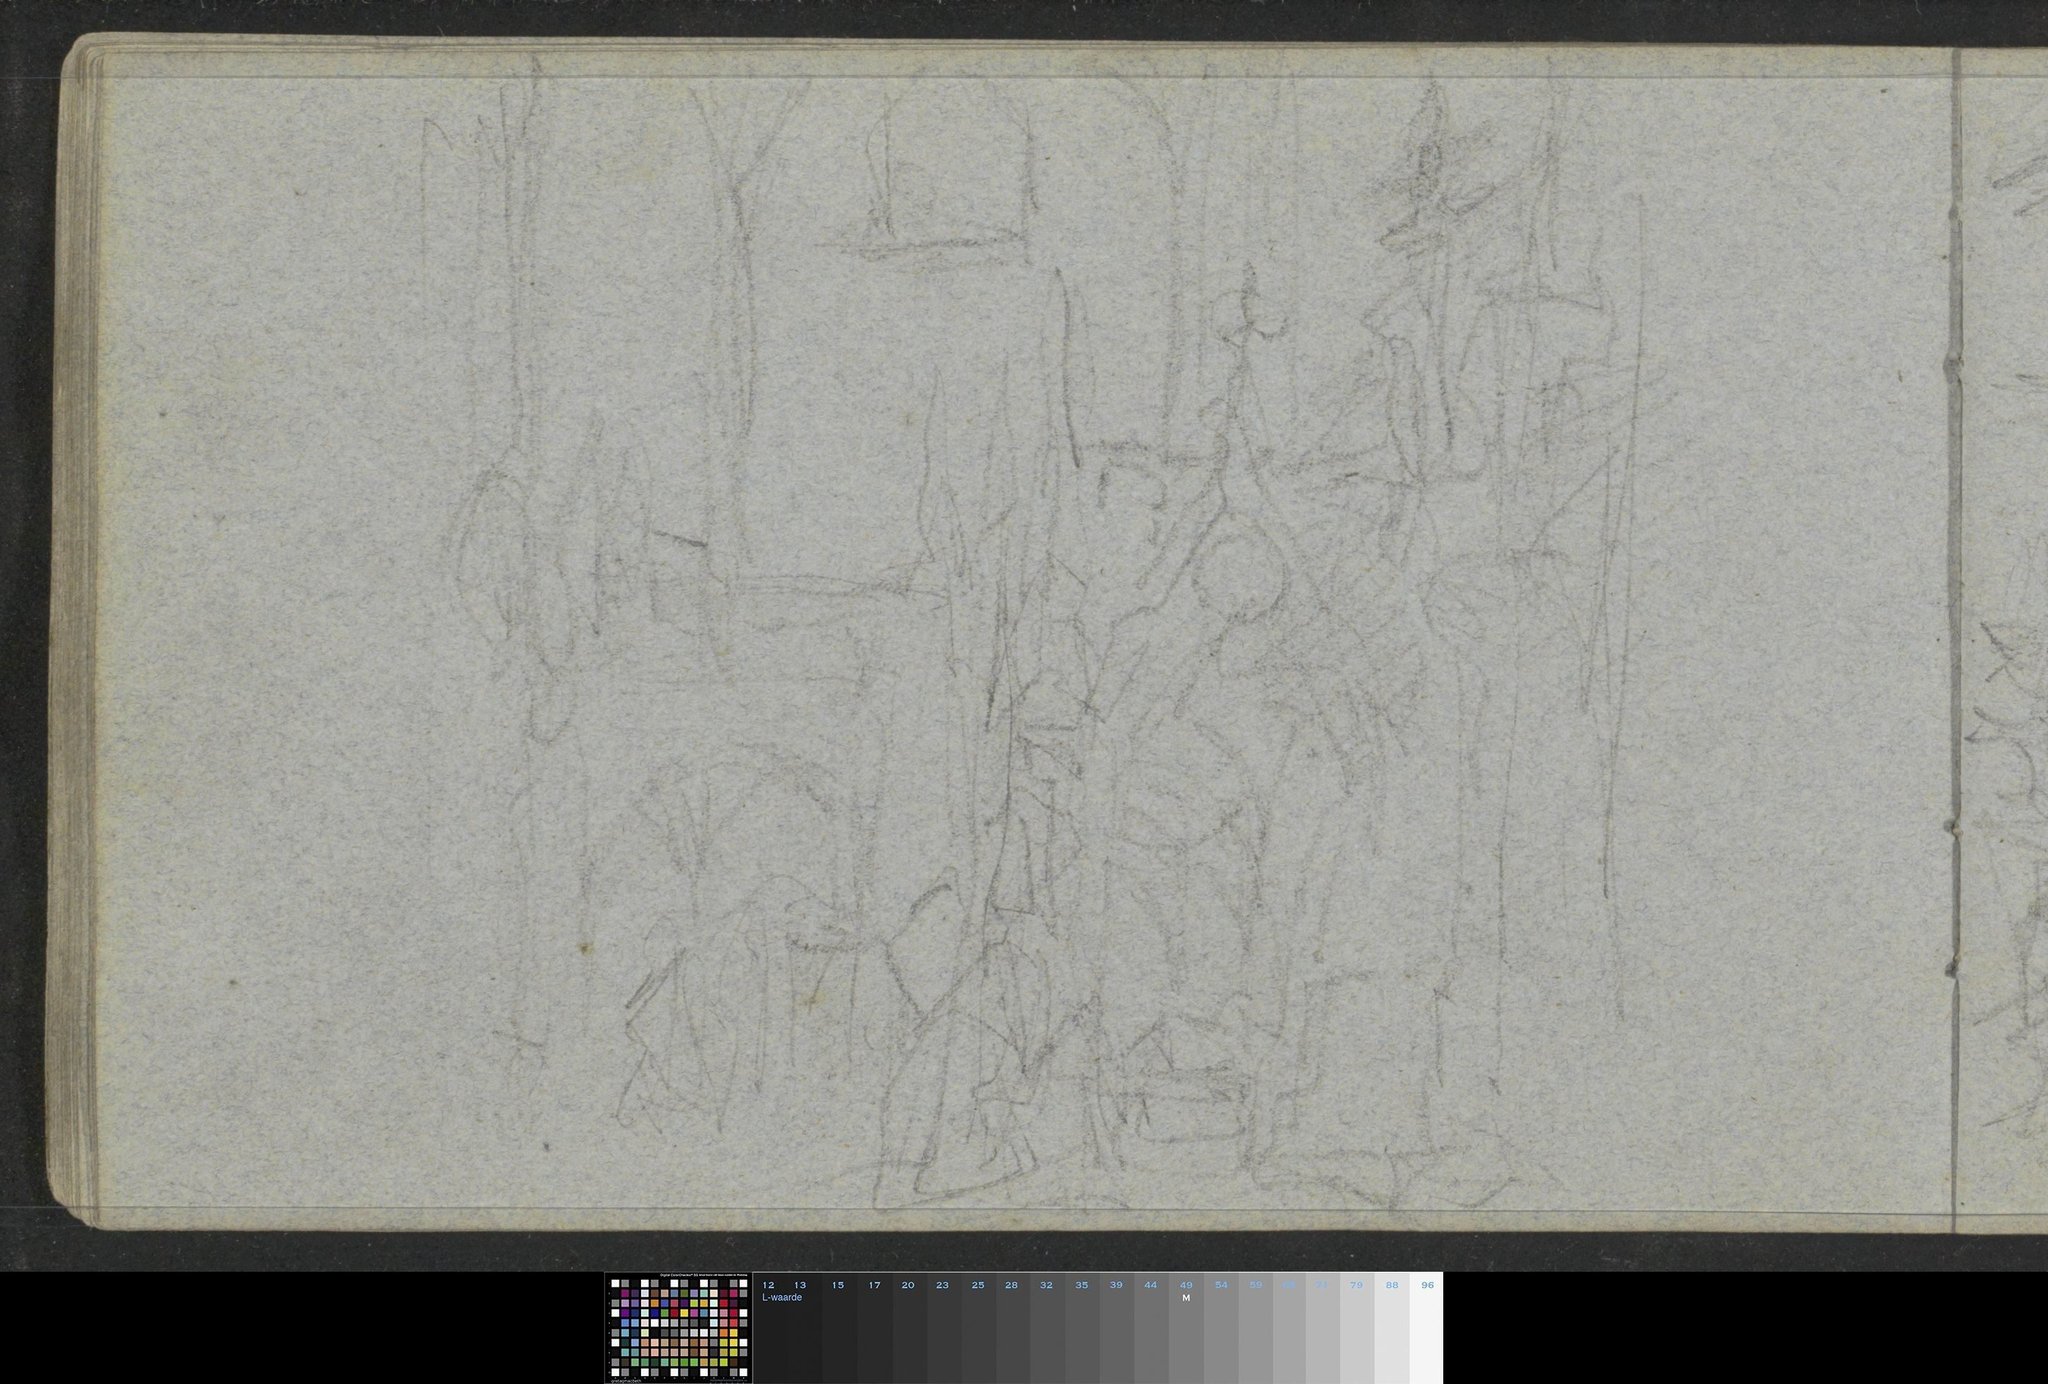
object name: sketchbook leaf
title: Architectuurstudie, mogelijk een gotische kerk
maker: matthijs maris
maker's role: draughtsman, painter, print maker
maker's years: 1839-1917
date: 1849-1917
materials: paper, pencil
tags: architecture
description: Blad 14 verso uit een schetsboek met 35 bladen.